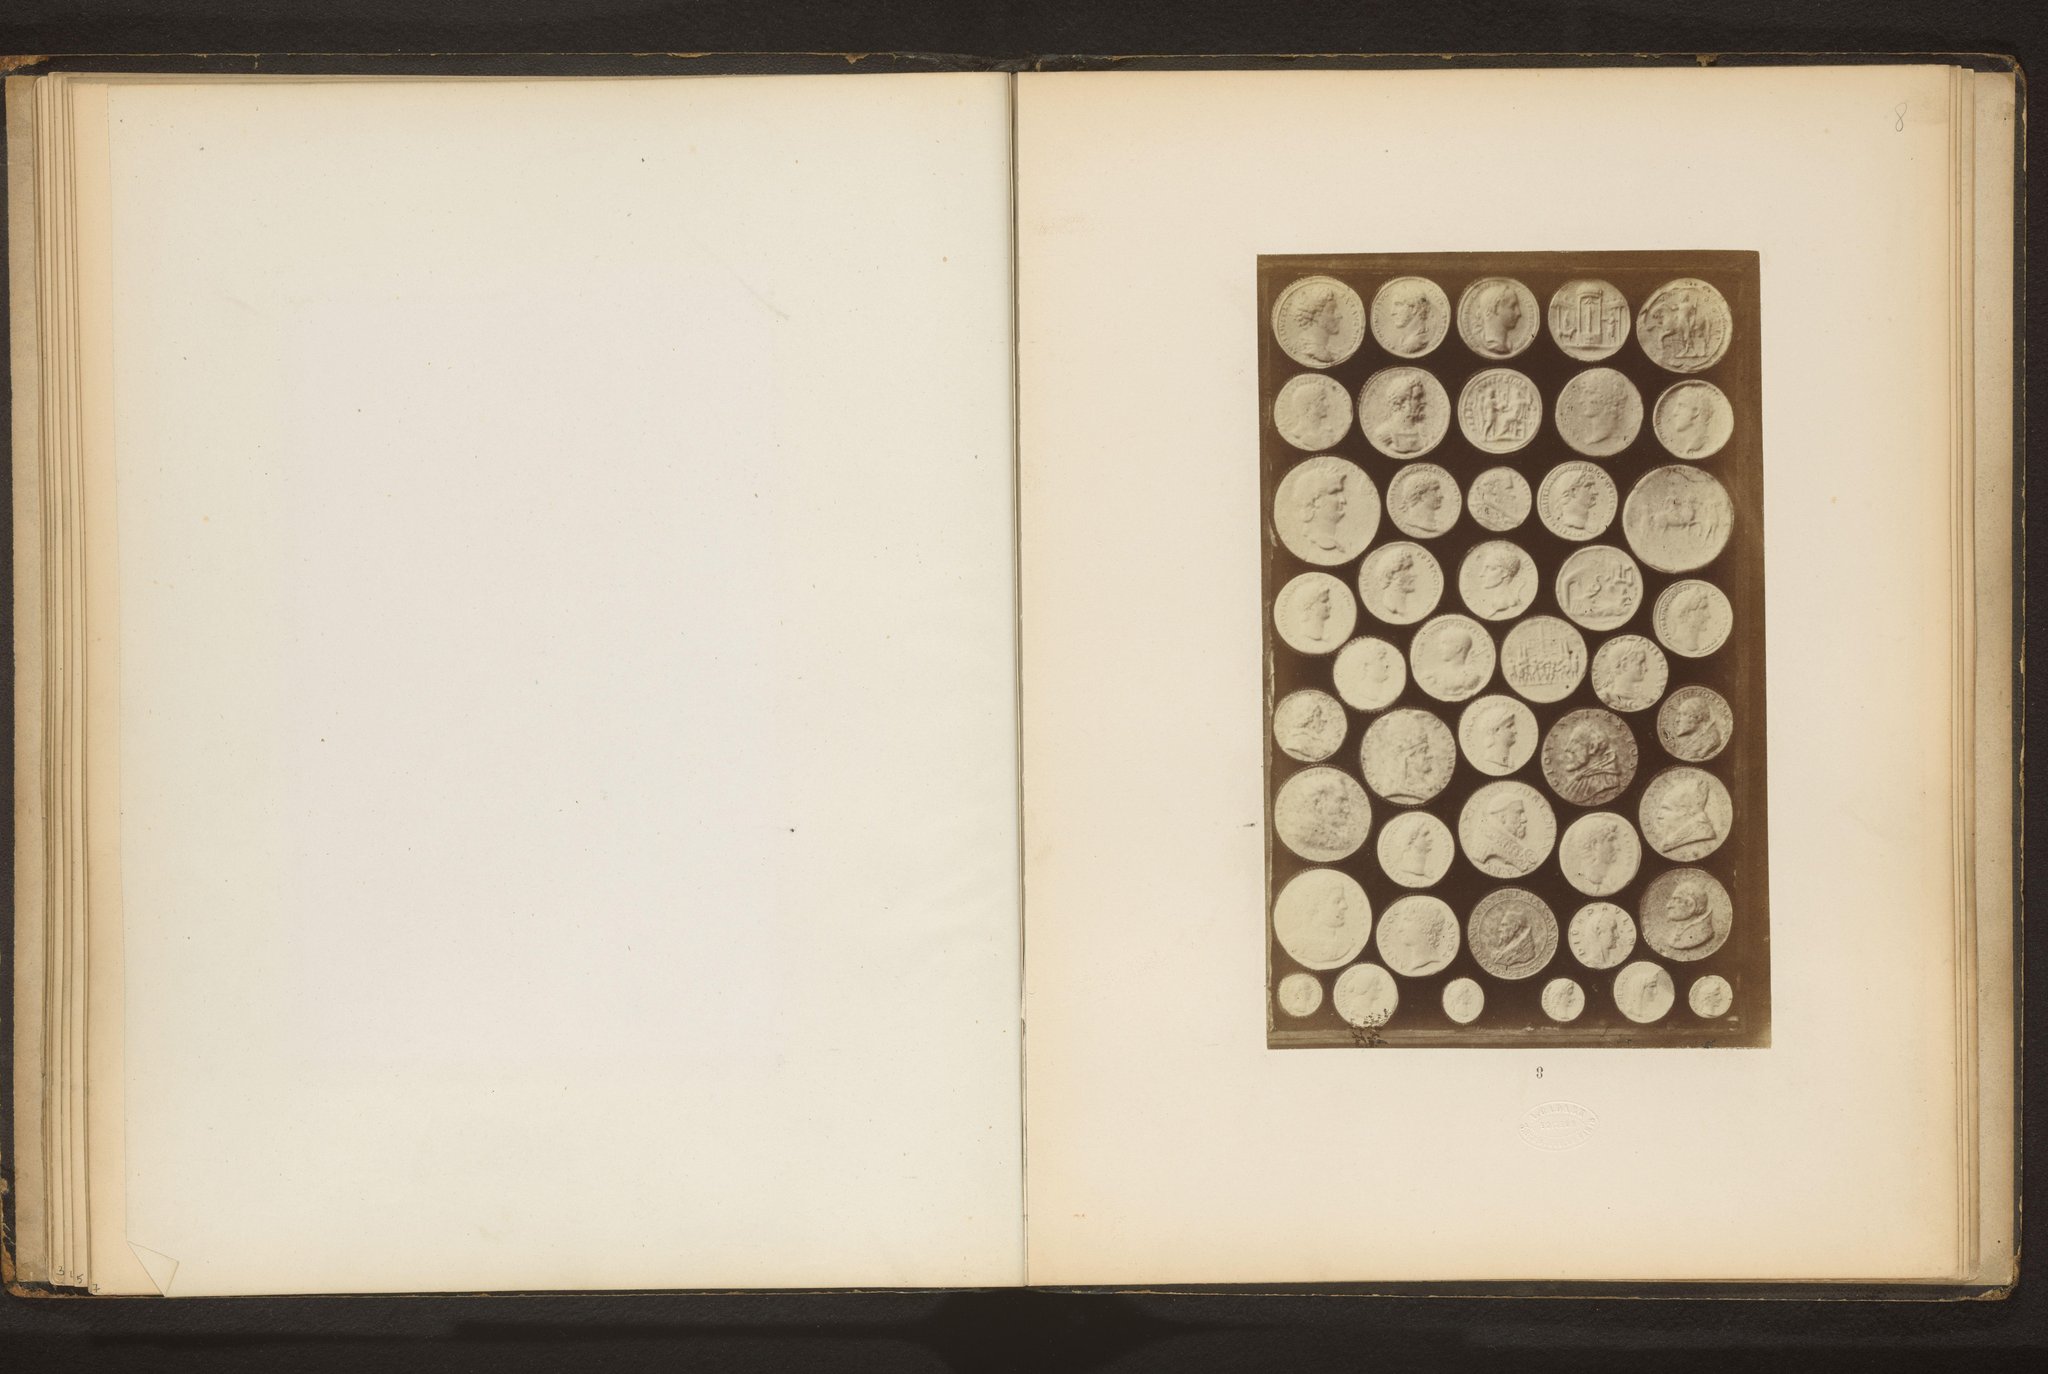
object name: photograph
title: Antieke medailles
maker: Anonymous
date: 1849-1859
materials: photographic support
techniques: albumen print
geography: rome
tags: medal (considered as a piece of sculpture, regardless of its specific function)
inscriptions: name: ‘A. Cadart 3. Rue St. Fiacre Paris Editeur’, number: ‘8’